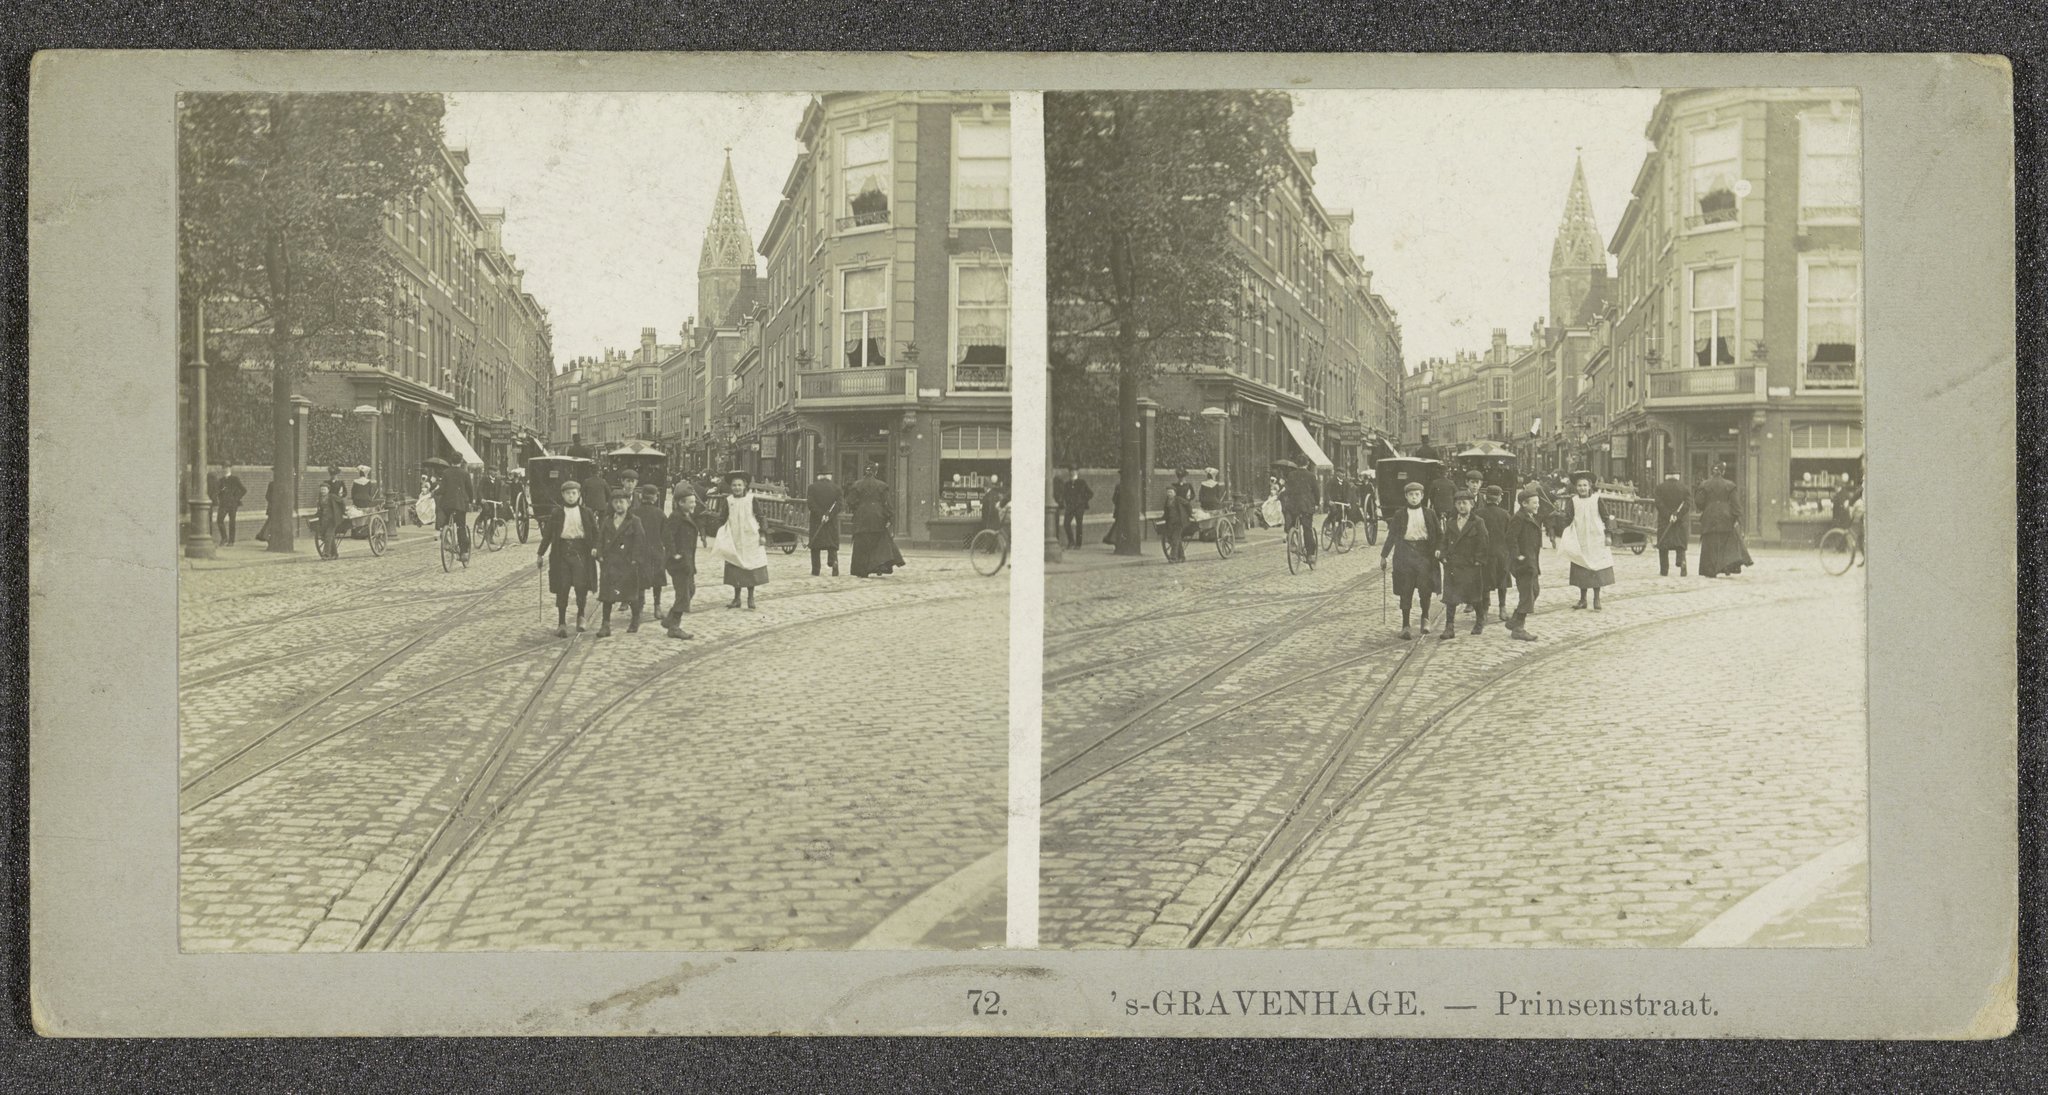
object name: stereograph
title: Gezicht op de Prinsestraat in Den Haag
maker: Anonymous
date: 1882-1920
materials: cardboard, photographic support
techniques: gelatin silver print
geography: the hague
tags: urban housing, street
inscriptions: number: ‘72.’